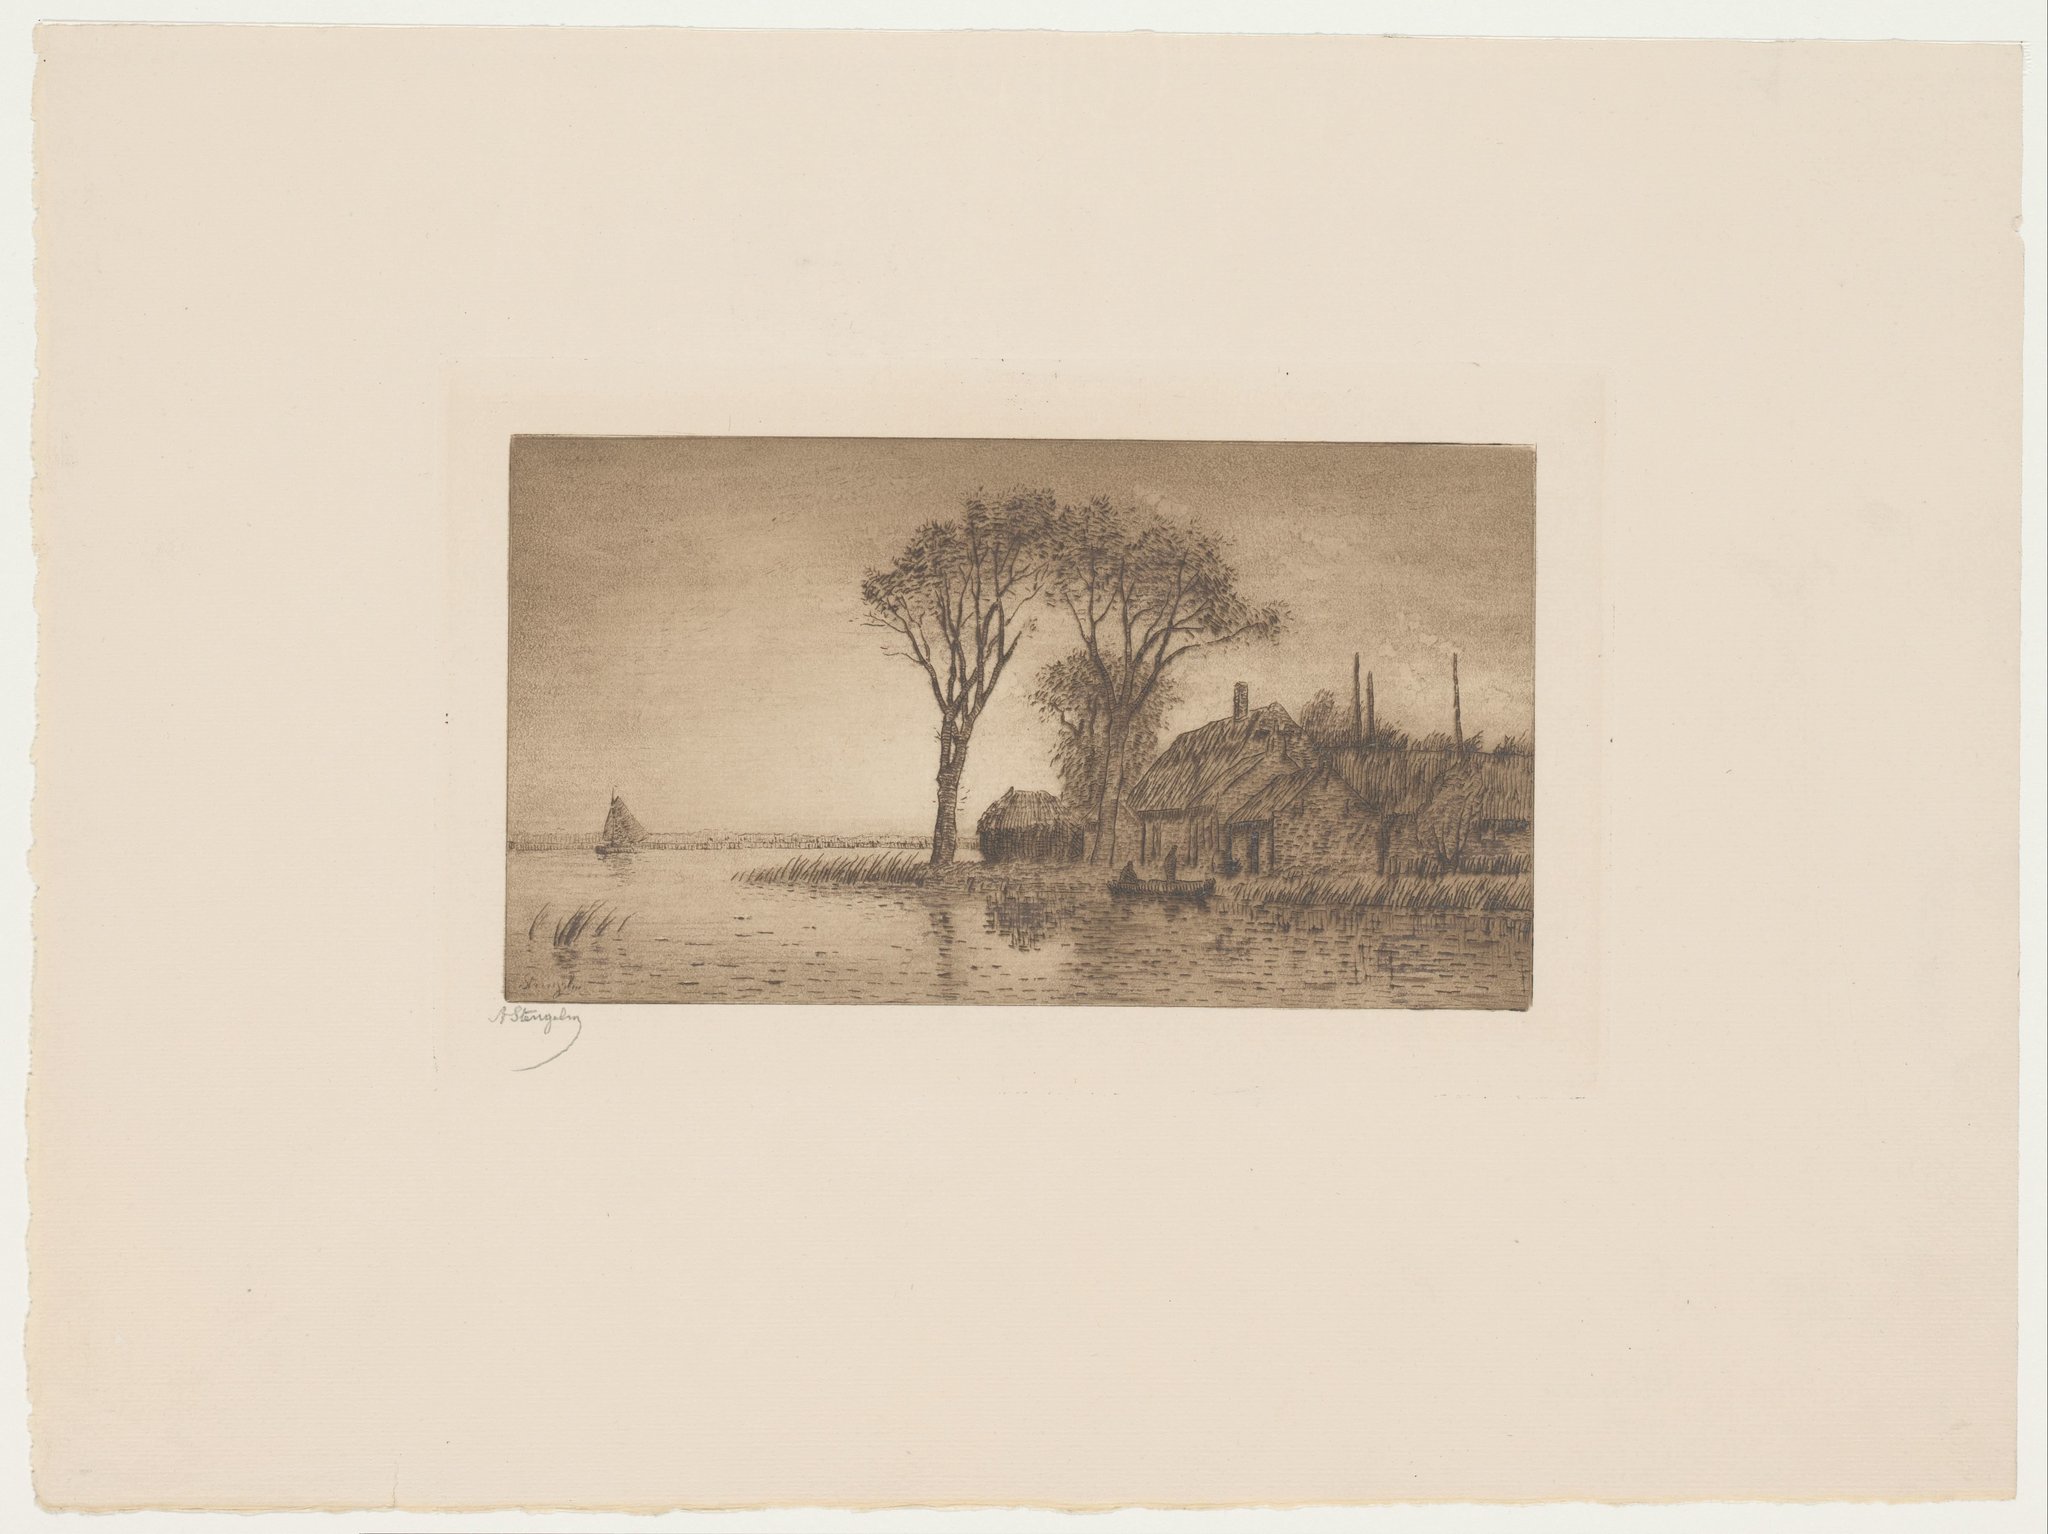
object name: print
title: Landschap met boerderij in de bocht van een rivier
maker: alphonse stengelin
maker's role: painter, print maker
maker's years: 1852-1938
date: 1862-1913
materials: paper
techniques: aquatint, etching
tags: landscapes with waters, waterscapes, seascapes (in the temperate zone), farm (building)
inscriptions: collector's mark: Lugt 2233